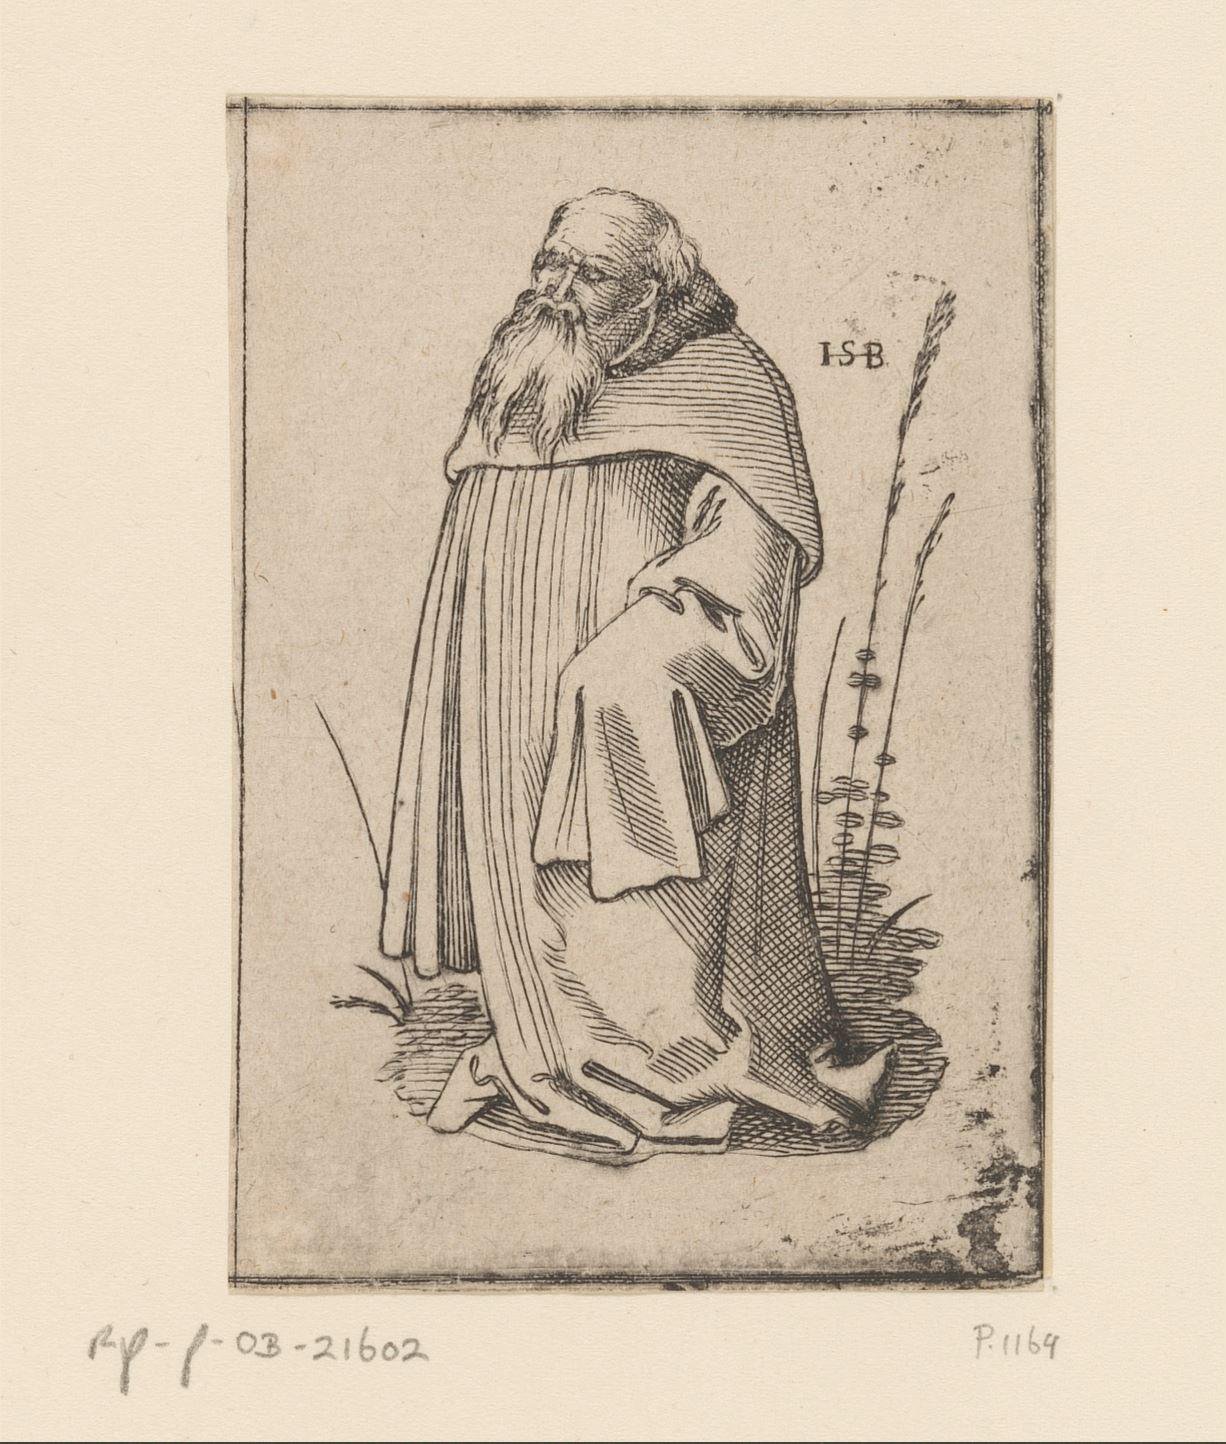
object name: print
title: Kostuums van geestelijken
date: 1526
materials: paper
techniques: engraving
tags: liturgical vestments, canonicals, monastic orders, monastic life ~ roman catholic church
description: Onderdeel van een serie van 28 gegraveerde kopieën in de andere richting naar Hans Sebald Behams "Das Papstthum mit seinen Gliedern", 1526.